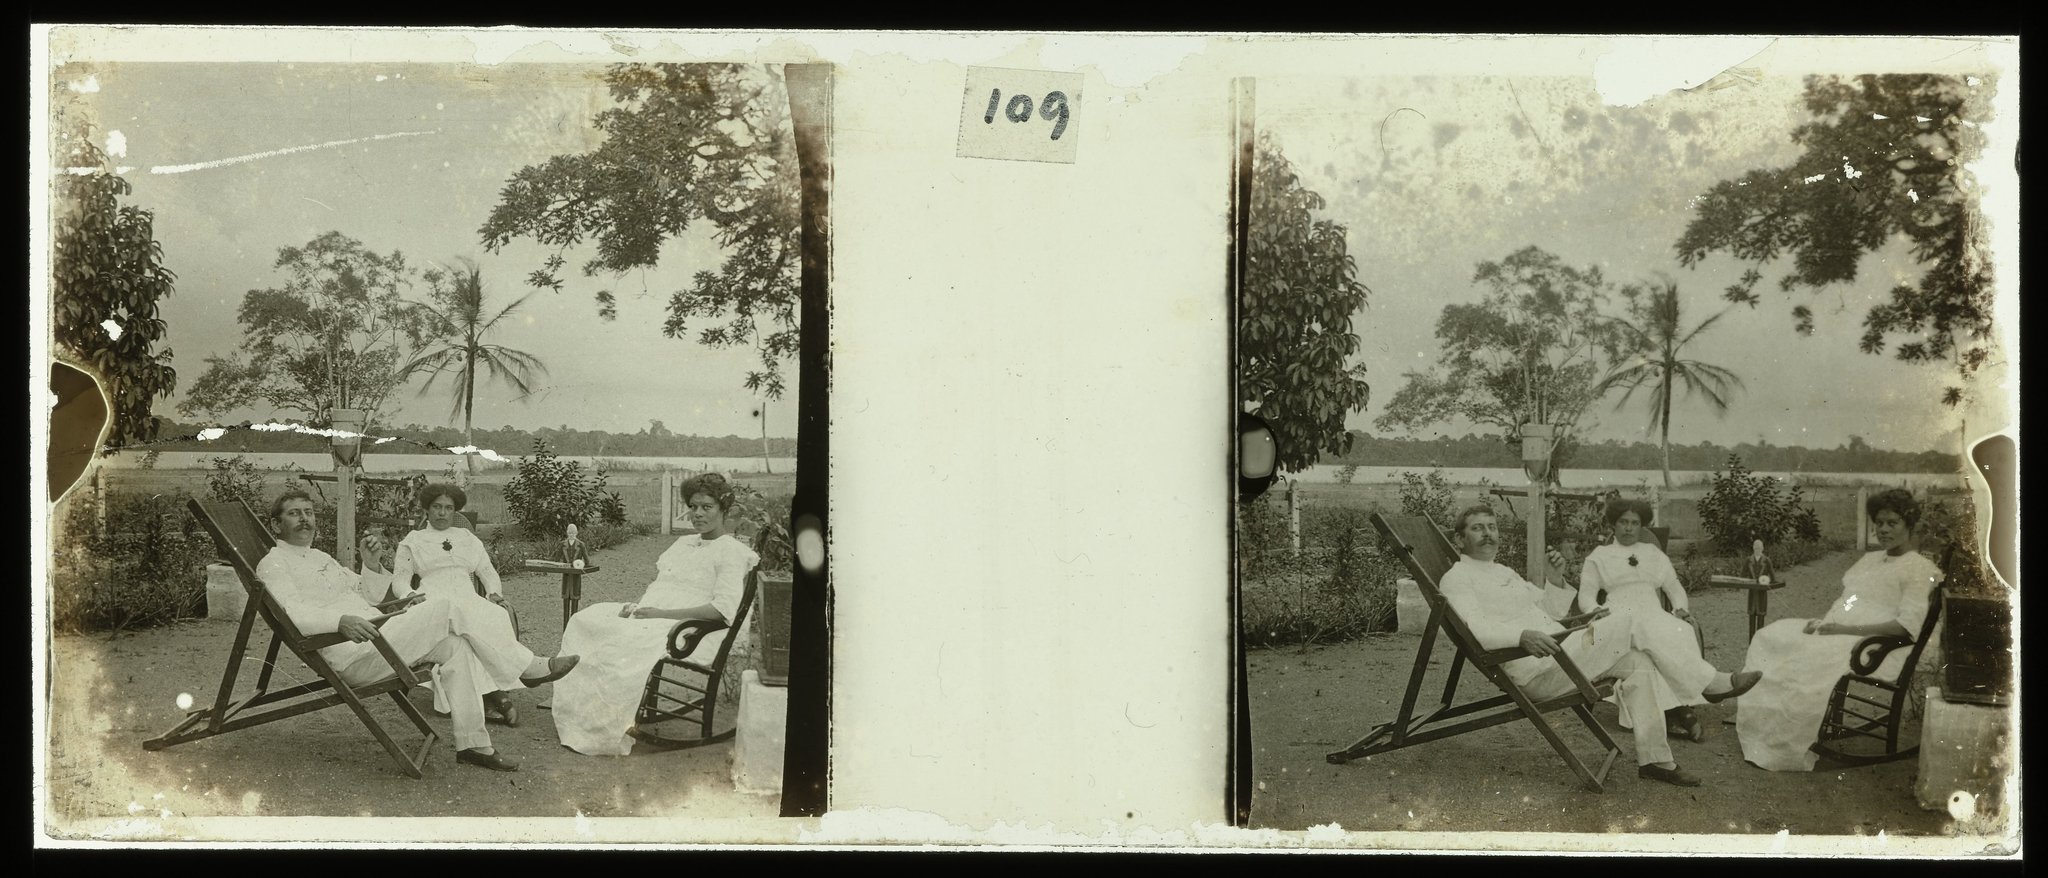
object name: stereograph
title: Theodoor Brouwers, Ada van Lierop en Lize Brouwers op het terras van plantage Accaribo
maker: Anonymous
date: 1913-1930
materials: glass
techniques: photography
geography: suriname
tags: haarlem, theodoor brouwers, plantation, suriname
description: In de periode 1911-1932 woonde op plantage Accaribo in Suriname de familie Brouwers van wie de foto's afkomstig zijn. Rond 1910 vond Theodoor Brouwers werk op plantage Accaribo. In 1929 werd hij eigenaar van de plantage. Op Accaribo werden in zijn tijd bananen geproduceerd en wat koffie.